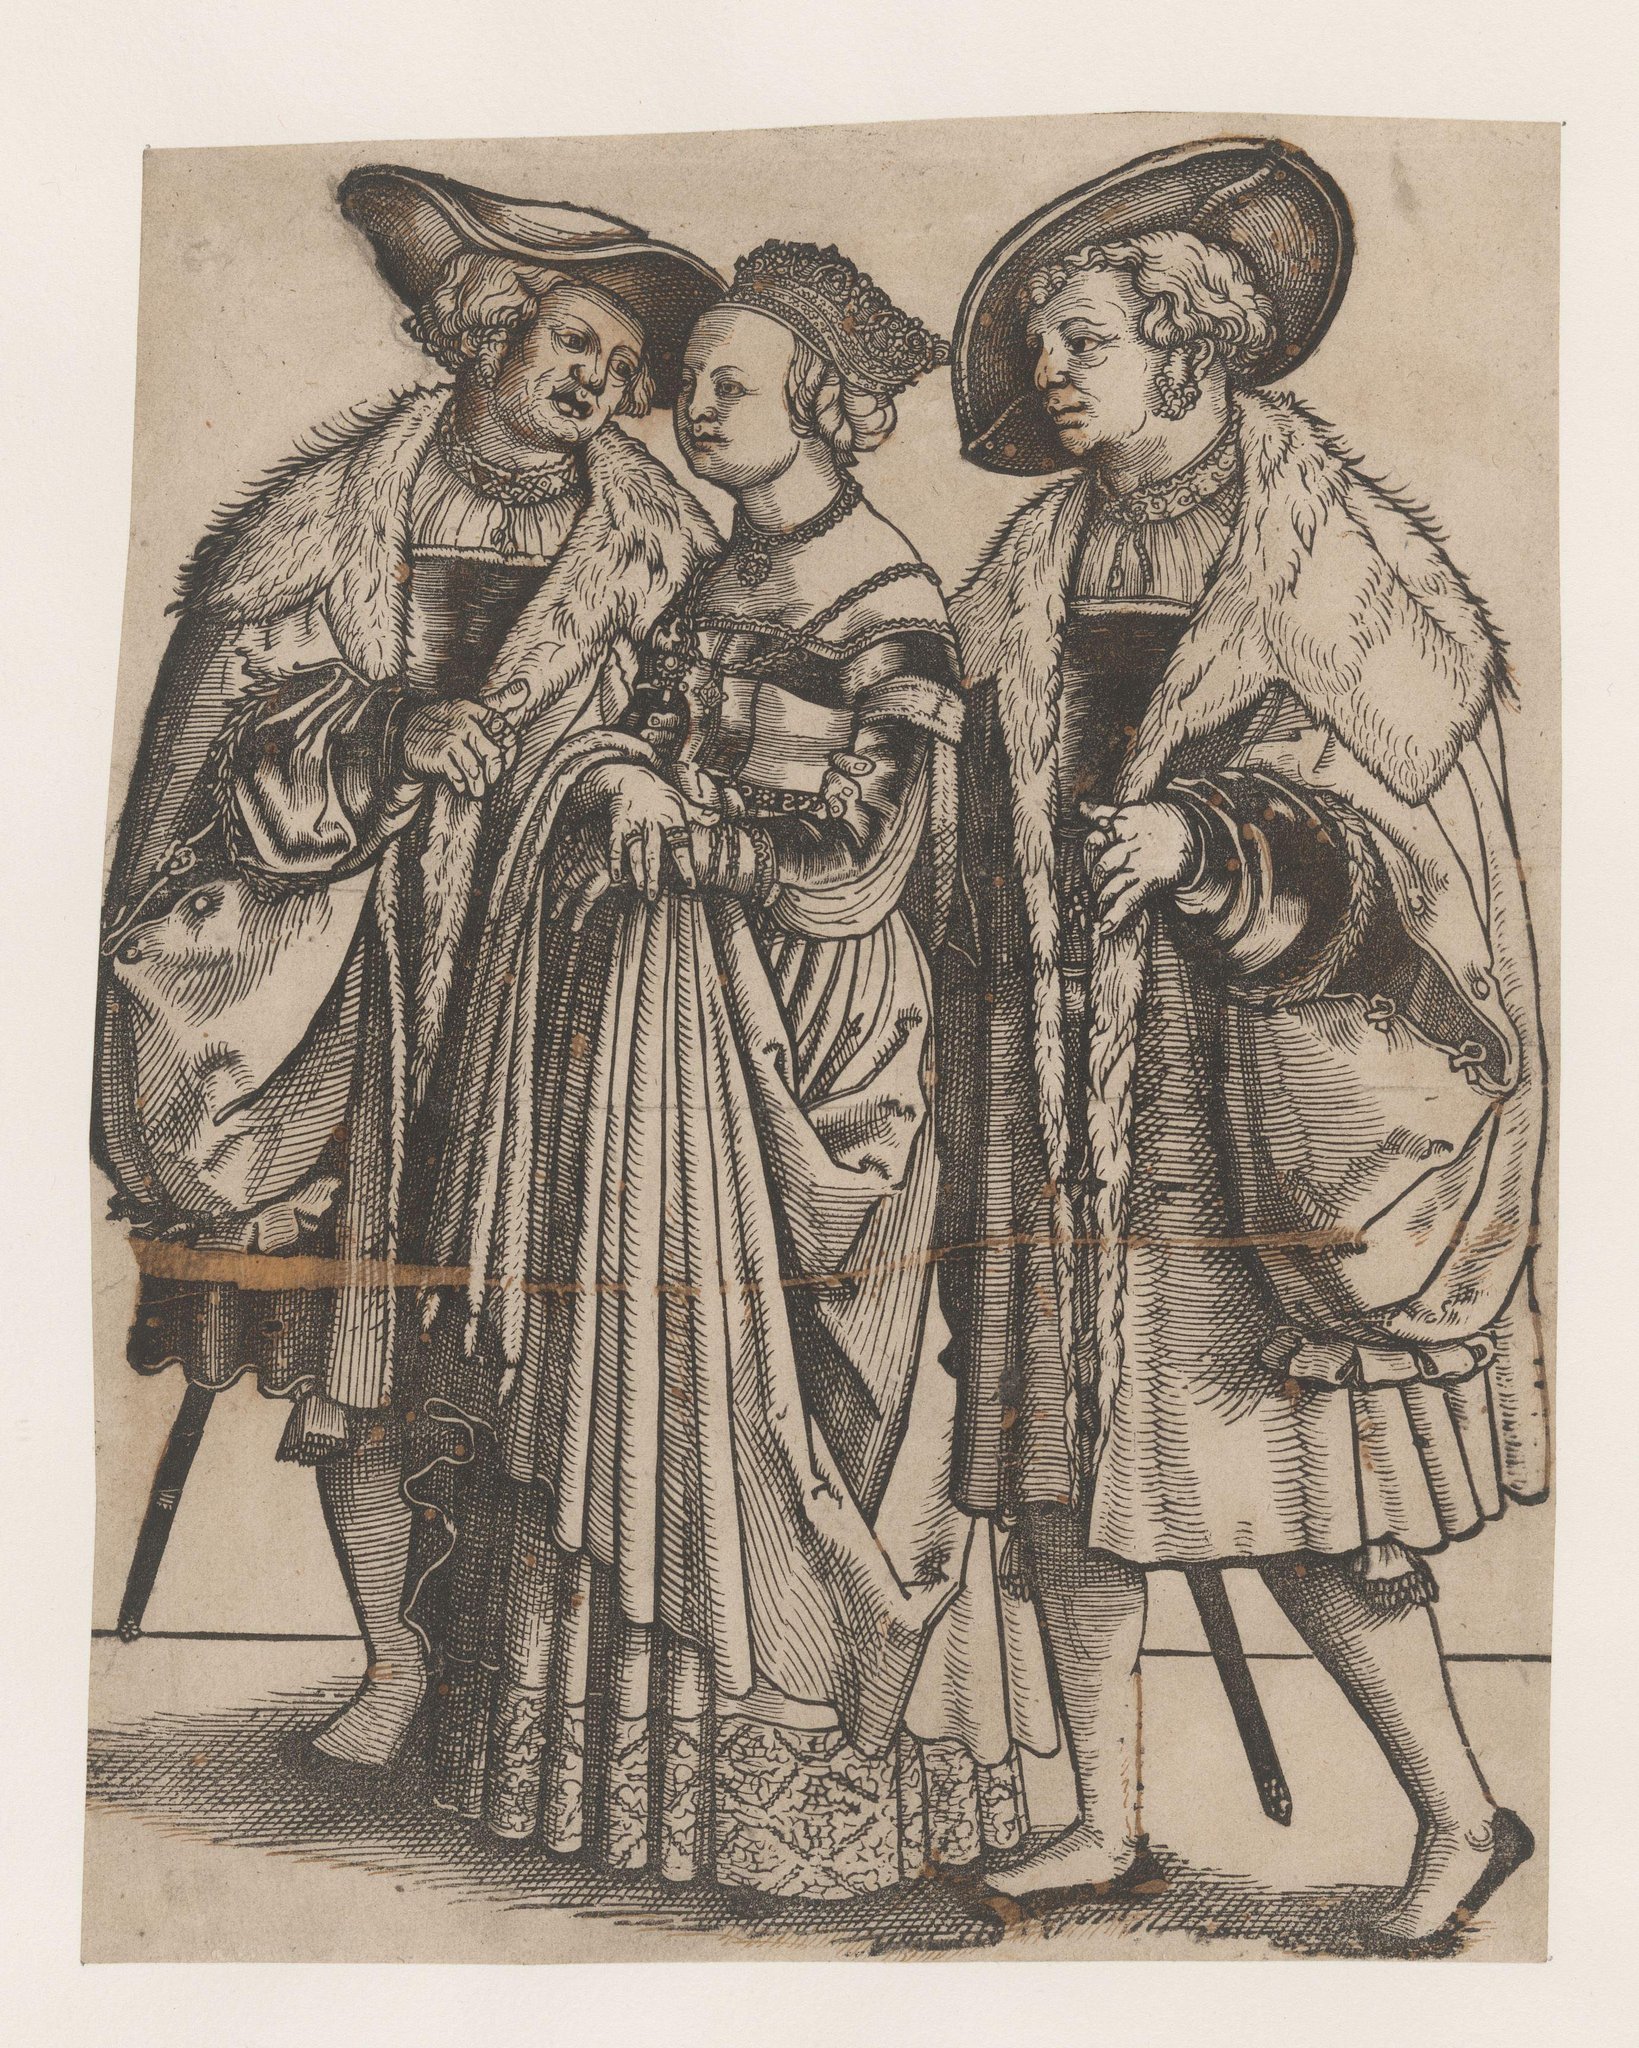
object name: print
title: Bruid tussen twee bruidsjonkers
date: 1510-1550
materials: paper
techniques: woodcut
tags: bride (in wedding-dress), best man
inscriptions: collector's mark: Lugt 240